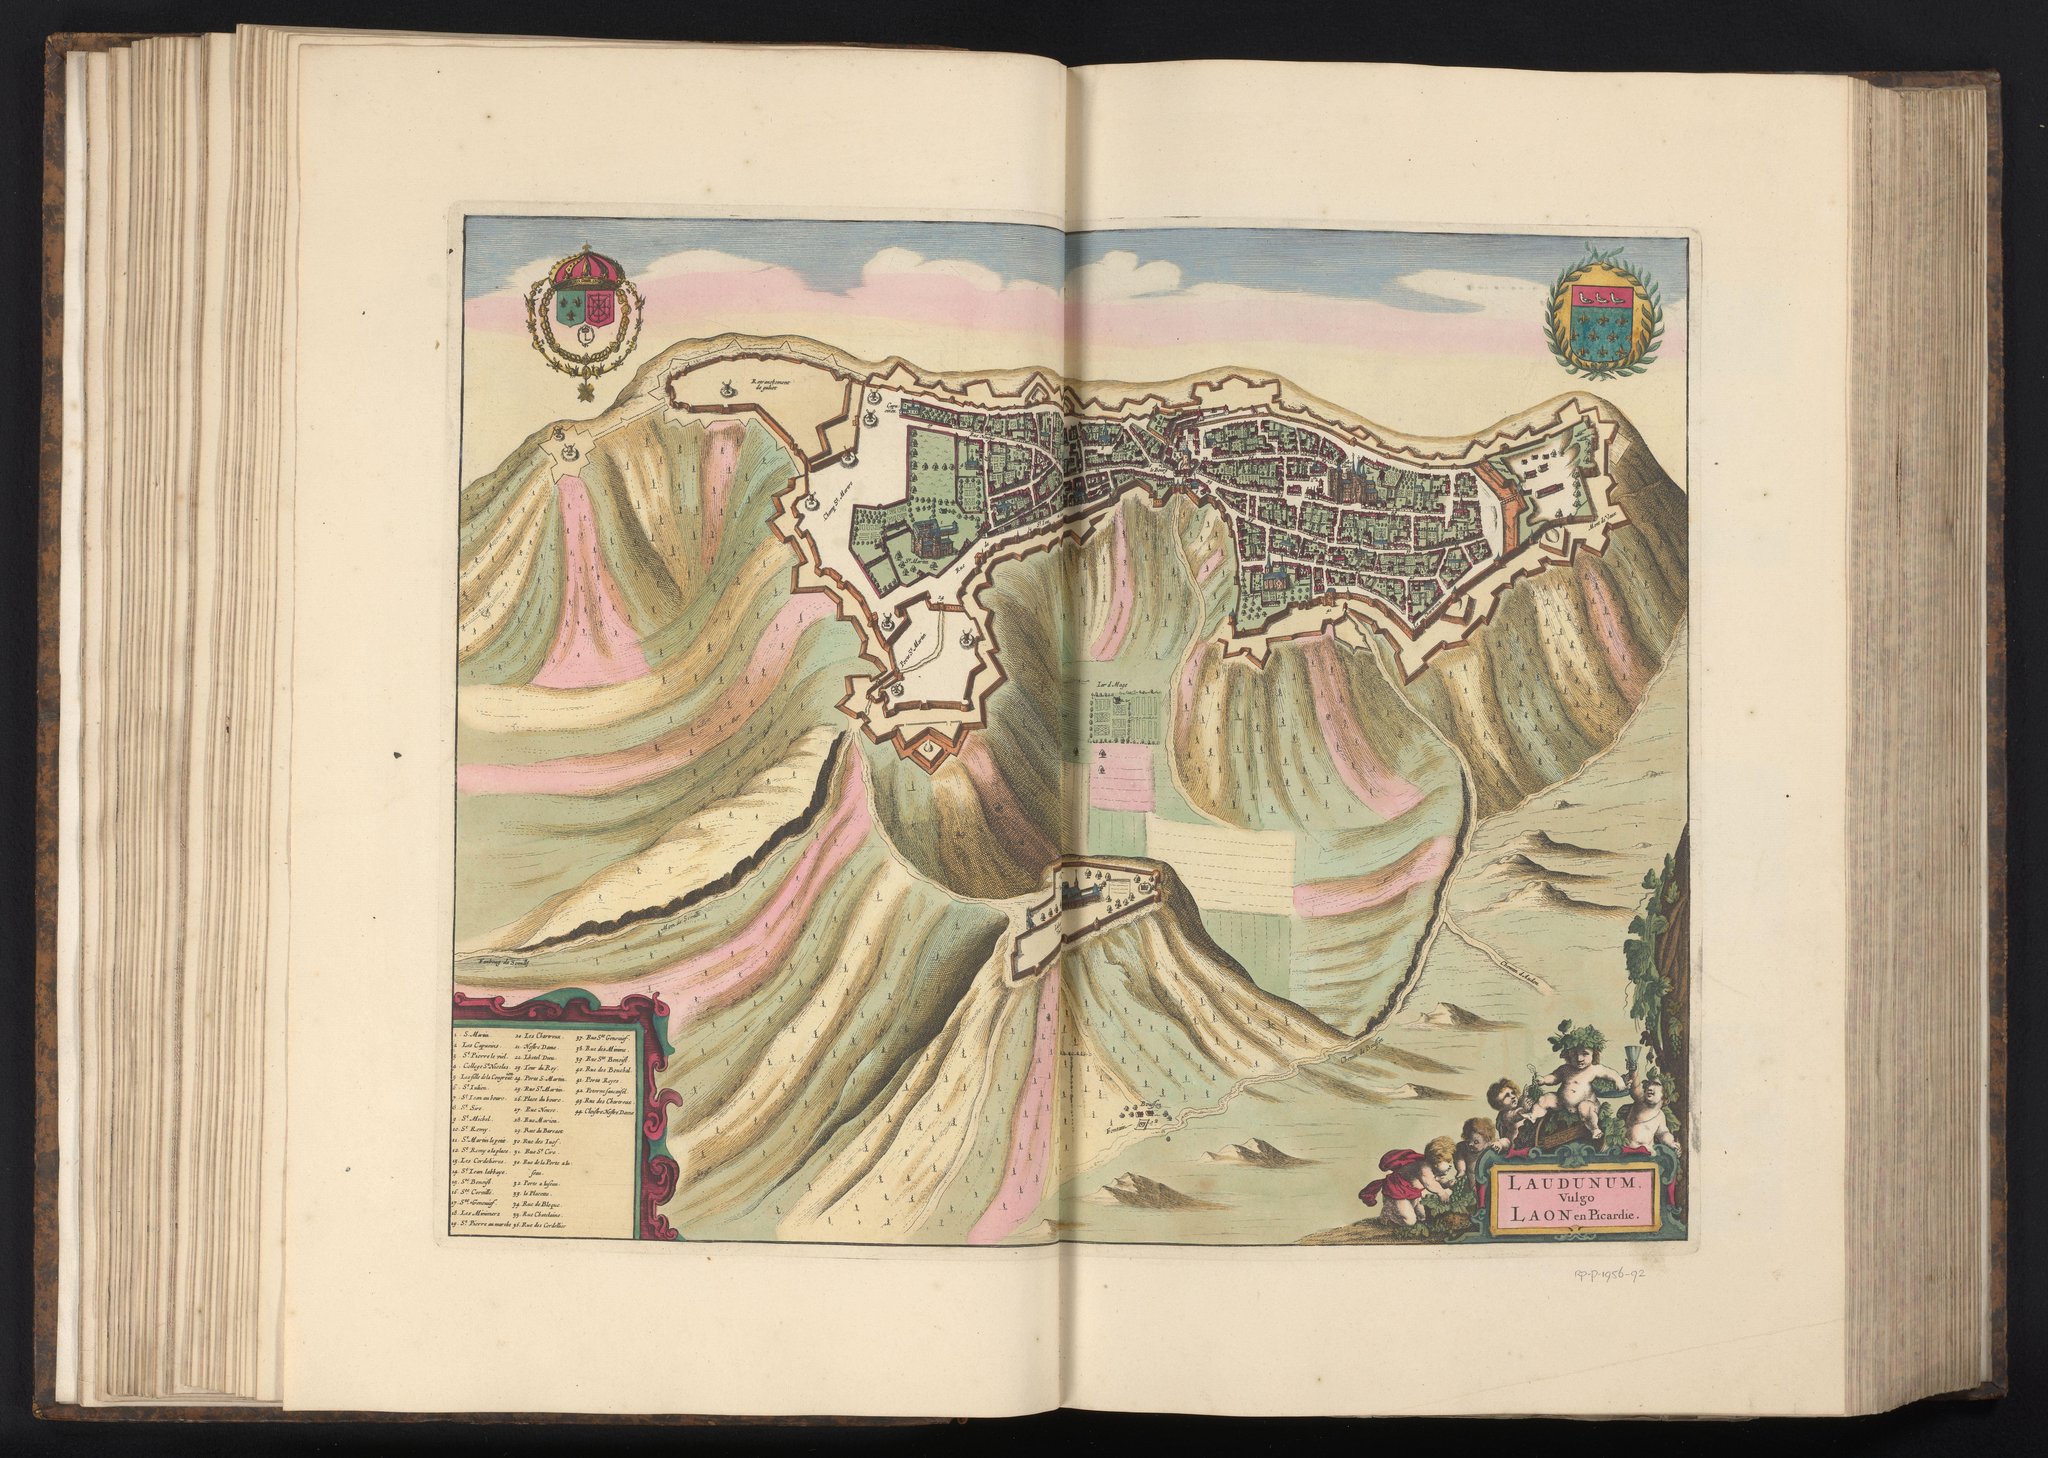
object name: album leaf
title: Laudunum, vulgo Laon en Picardie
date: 1657-1695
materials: paper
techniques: engraving, etching, hand coloring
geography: the hague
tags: maps of cities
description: Plattegrond gebruikt in diverse atlassen. Komt voor in: Theatrum exhibens celebriores Galliae et Helvetae urbes. Amsterdam: Johannes Janssonius, 1657, en in: Tooneel der vermaarste koop-steden. Amsterdam: Erven Johannes Janssonius van Waesberge, 1682, en in: Steden-boek van Europa, uytgesondert Nederland. Amsterdam: Frederik de Wit, ca. 1690 (en de Latijnse vertaling hiervan, 1695).